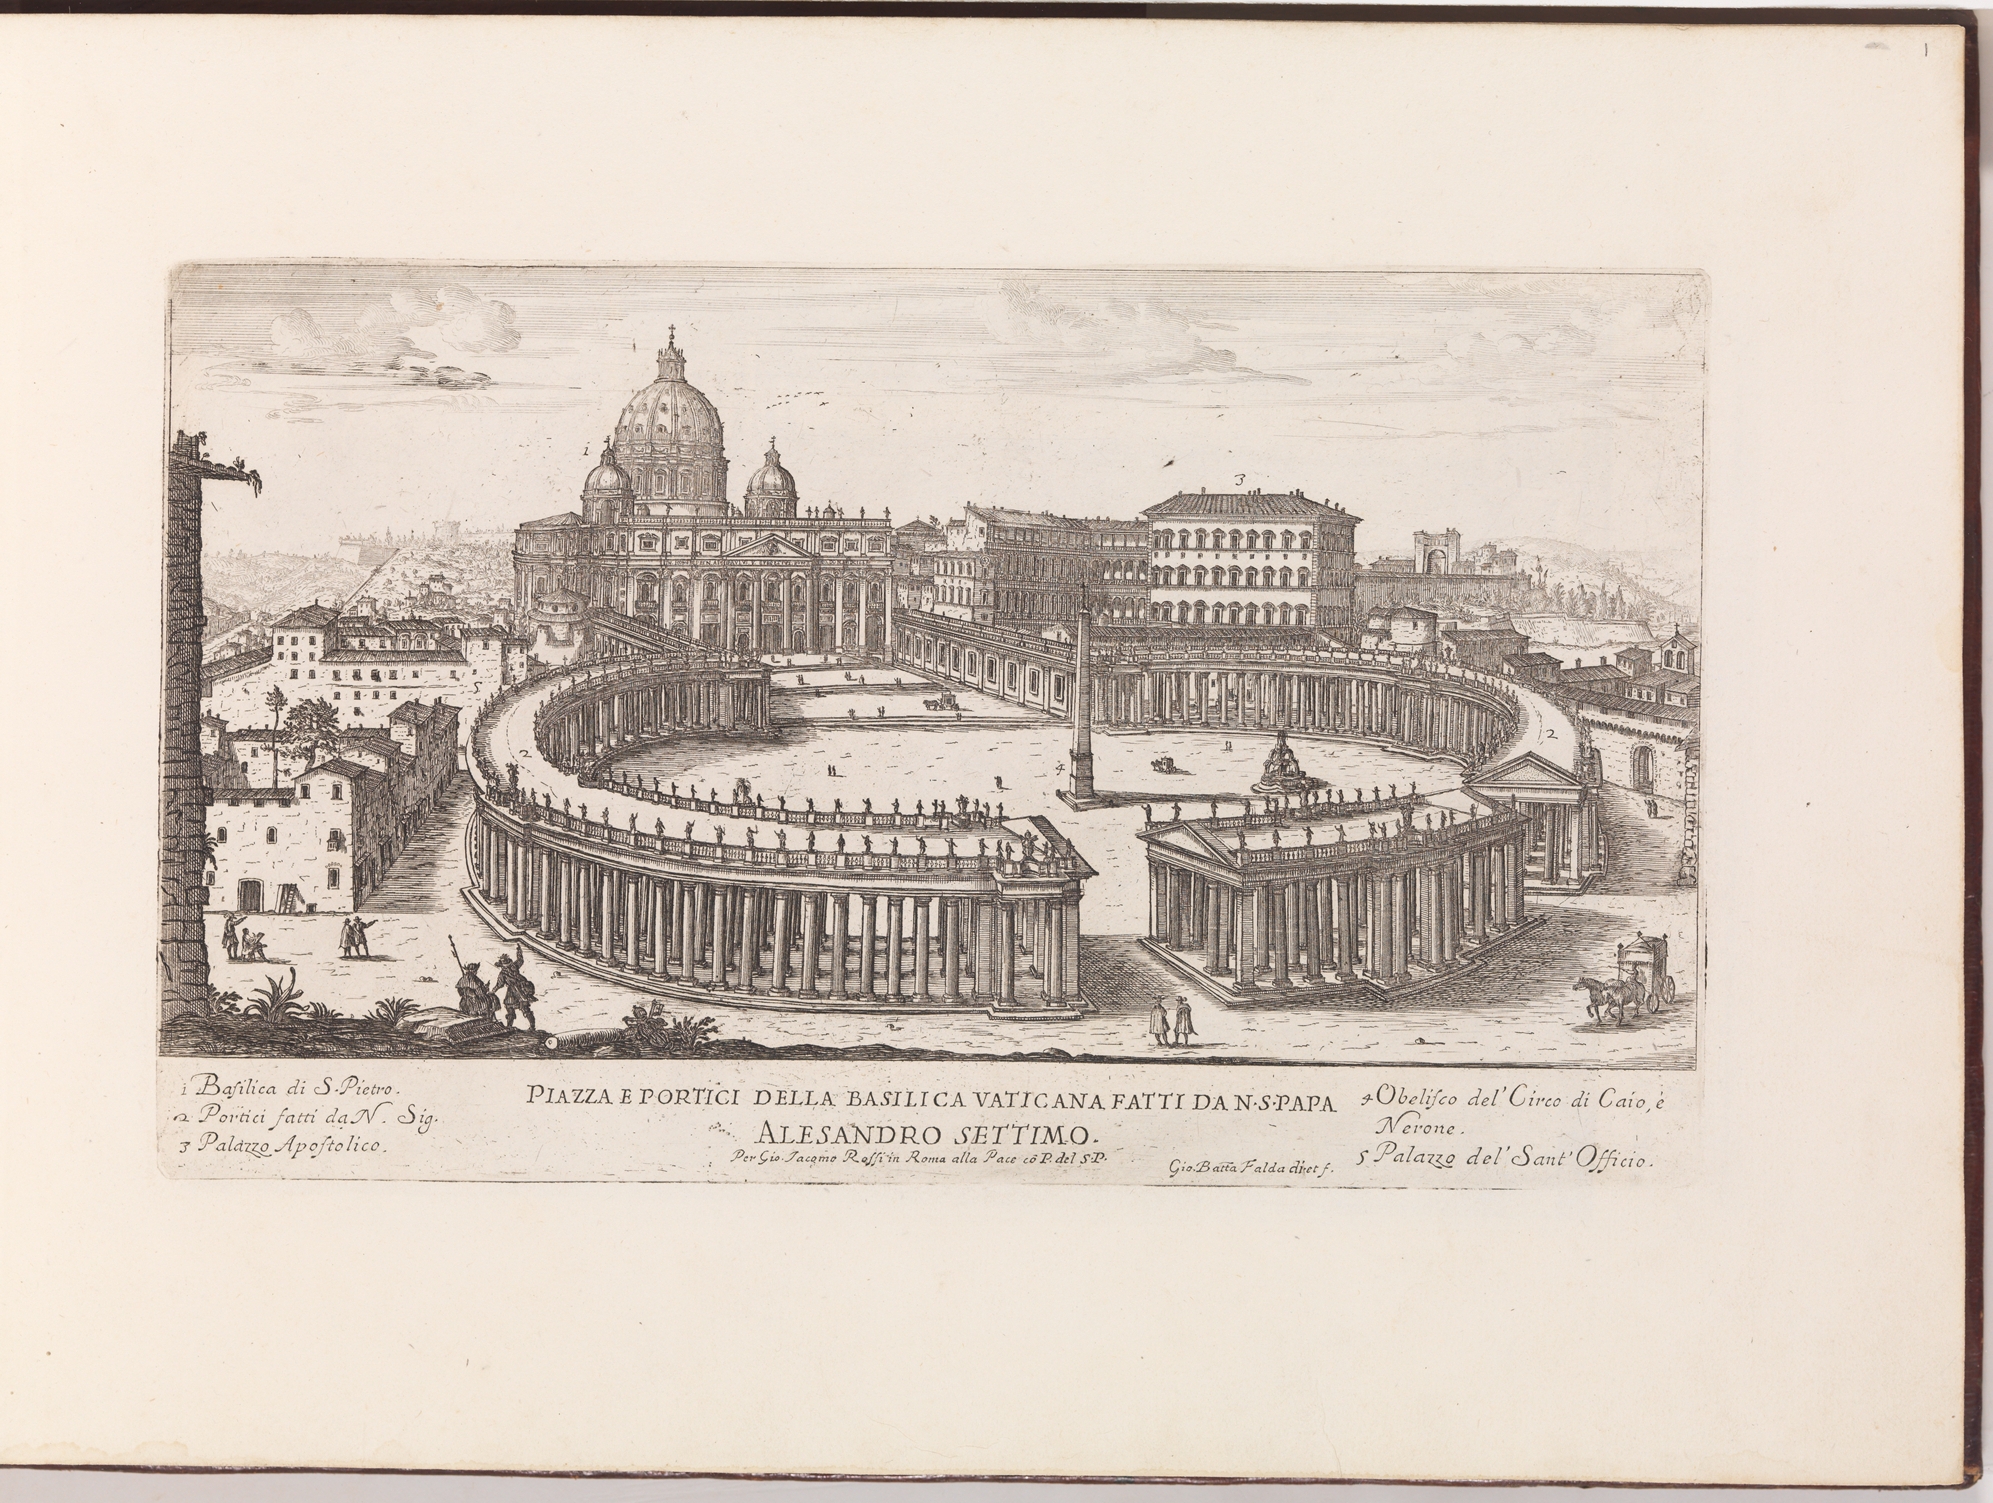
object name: collection ornament architecture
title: Piazza e Portici della Basilica Vaticana from: Il Nuovo Teatro delle Fabbriche, et Edificii, in Prospettiva di Rome Moderna (...)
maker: giovanni battista falda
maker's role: artist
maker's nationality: italian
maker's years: 1643-1678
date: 1665-1669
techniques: etching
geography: italy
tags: architecture,buildings,rome